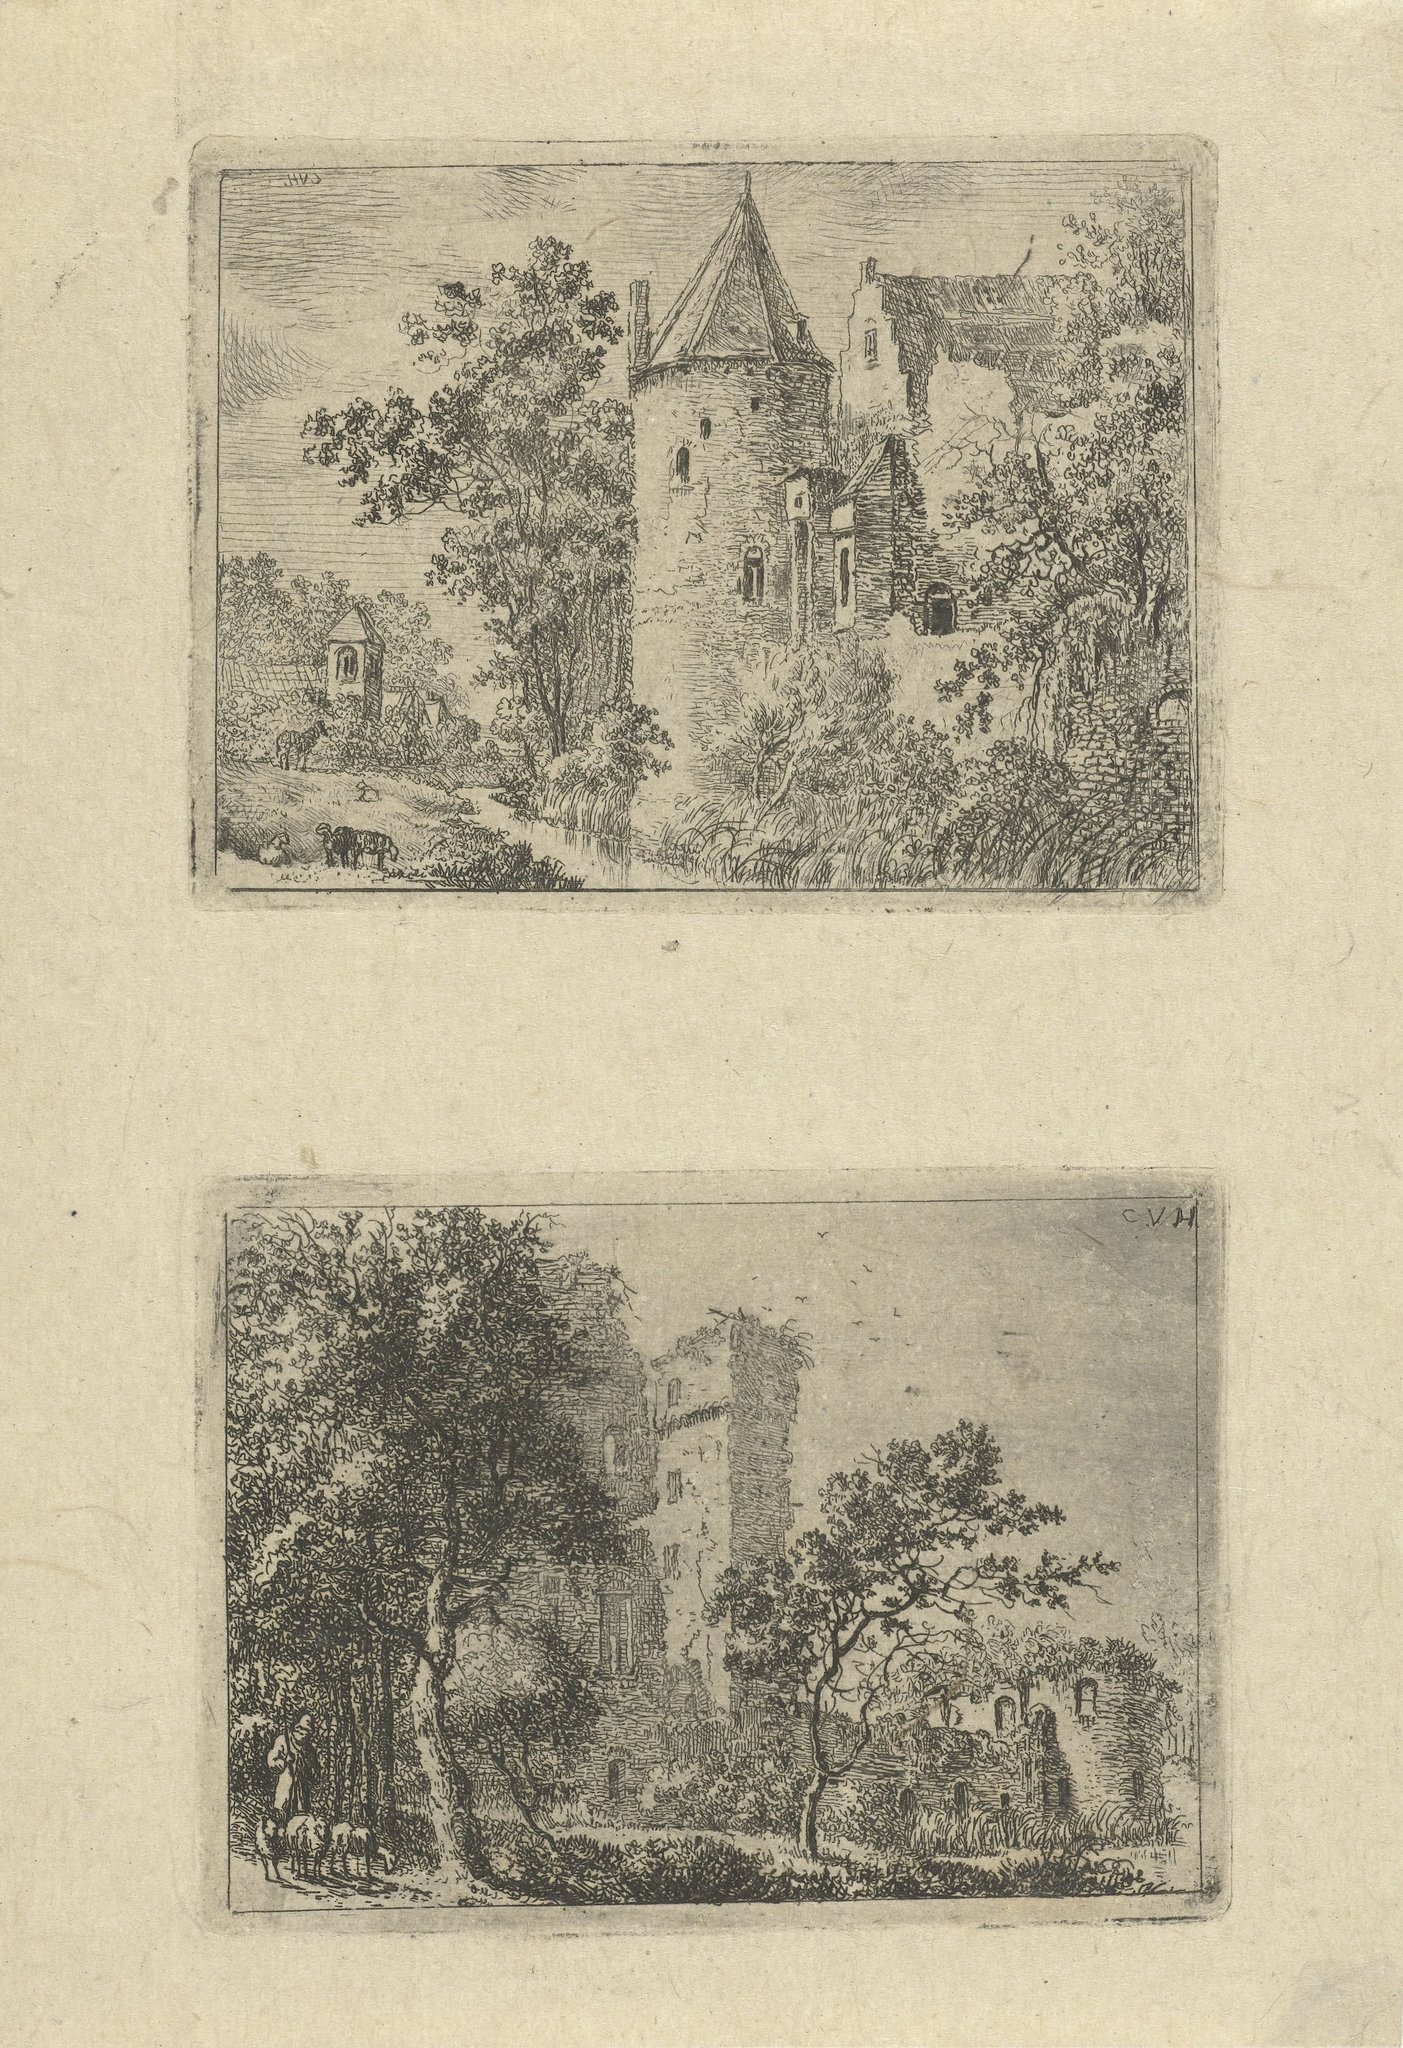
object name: print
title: Kasteel van Duurstede en ruïne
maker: cornelis van hardenbergh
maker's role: draughtsman, painter, print maker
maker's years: 1755-1843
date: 1770-1843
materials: paper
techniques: etching, intaglio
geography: netherlands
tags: cattle driving, cattle driver, landscape with tower or castle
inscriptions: collector's mark: Lugt 2228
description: Twee verschillende etsen op een blad van het kasteel Duurstede.